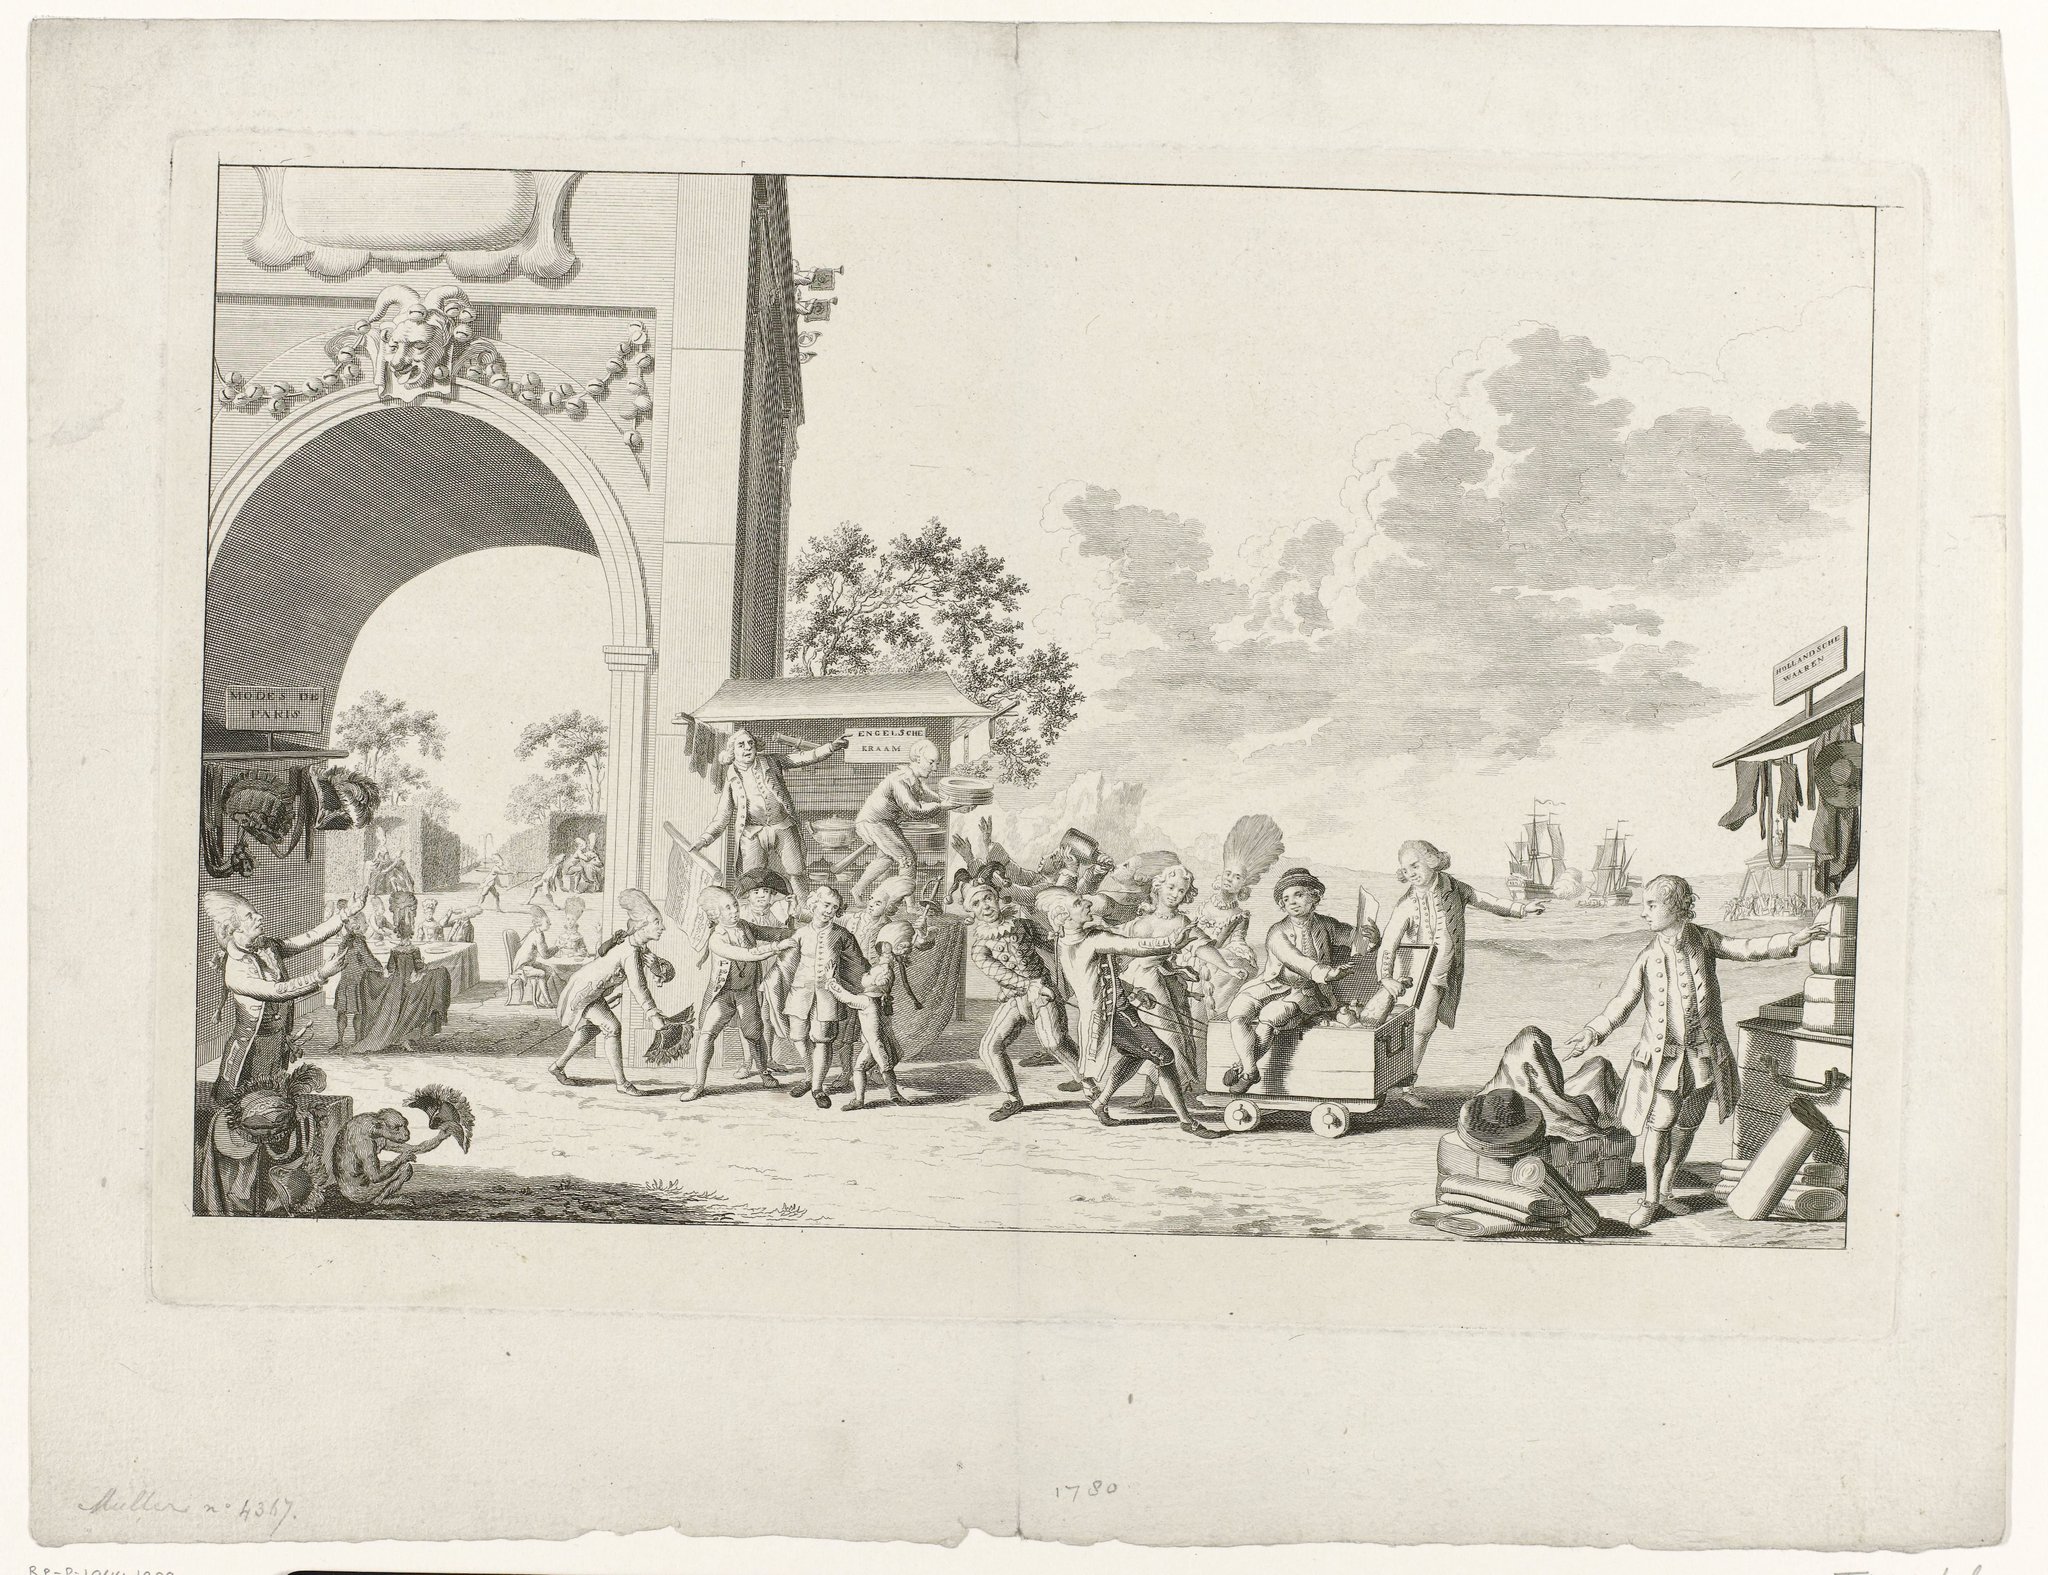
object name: print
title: Spotprent op de Engelsgezindheid van het jonge Holland, 1780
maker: Anonymous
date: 1780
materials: paper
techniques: engraving, etching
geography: northern netherlands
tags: wig, fashion, political caricatures and satires, fourth anglo-dutch war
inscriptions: collector's mark: Lugt 2228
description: Spotprent op de Engelsgezindheid, wuftheid en vermaakzucht van het jonge Holland, 1780. Een jonge rijke Hollander gezeten op een geldkist wijst de kraam met de Hollandse waren af en laat zich naar de Engelse Kraam en de Franse Kraam met de Modes de Paris rijden. Zie ook de pendant. Bij de prent behoort een afzonderlijk gedrukte uitleg (ontbreekt hier).